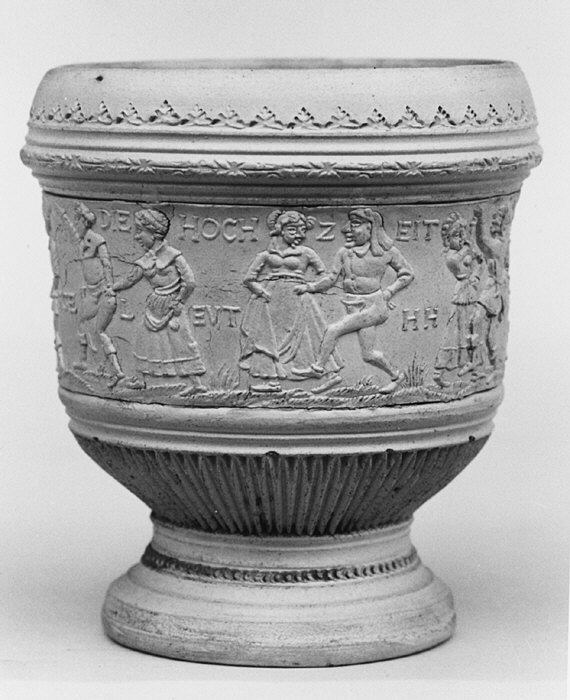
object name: marriage cup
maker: peter löwenick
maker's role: maker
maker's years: 1825-1835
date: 1830-1840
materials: stoneware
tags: men,women